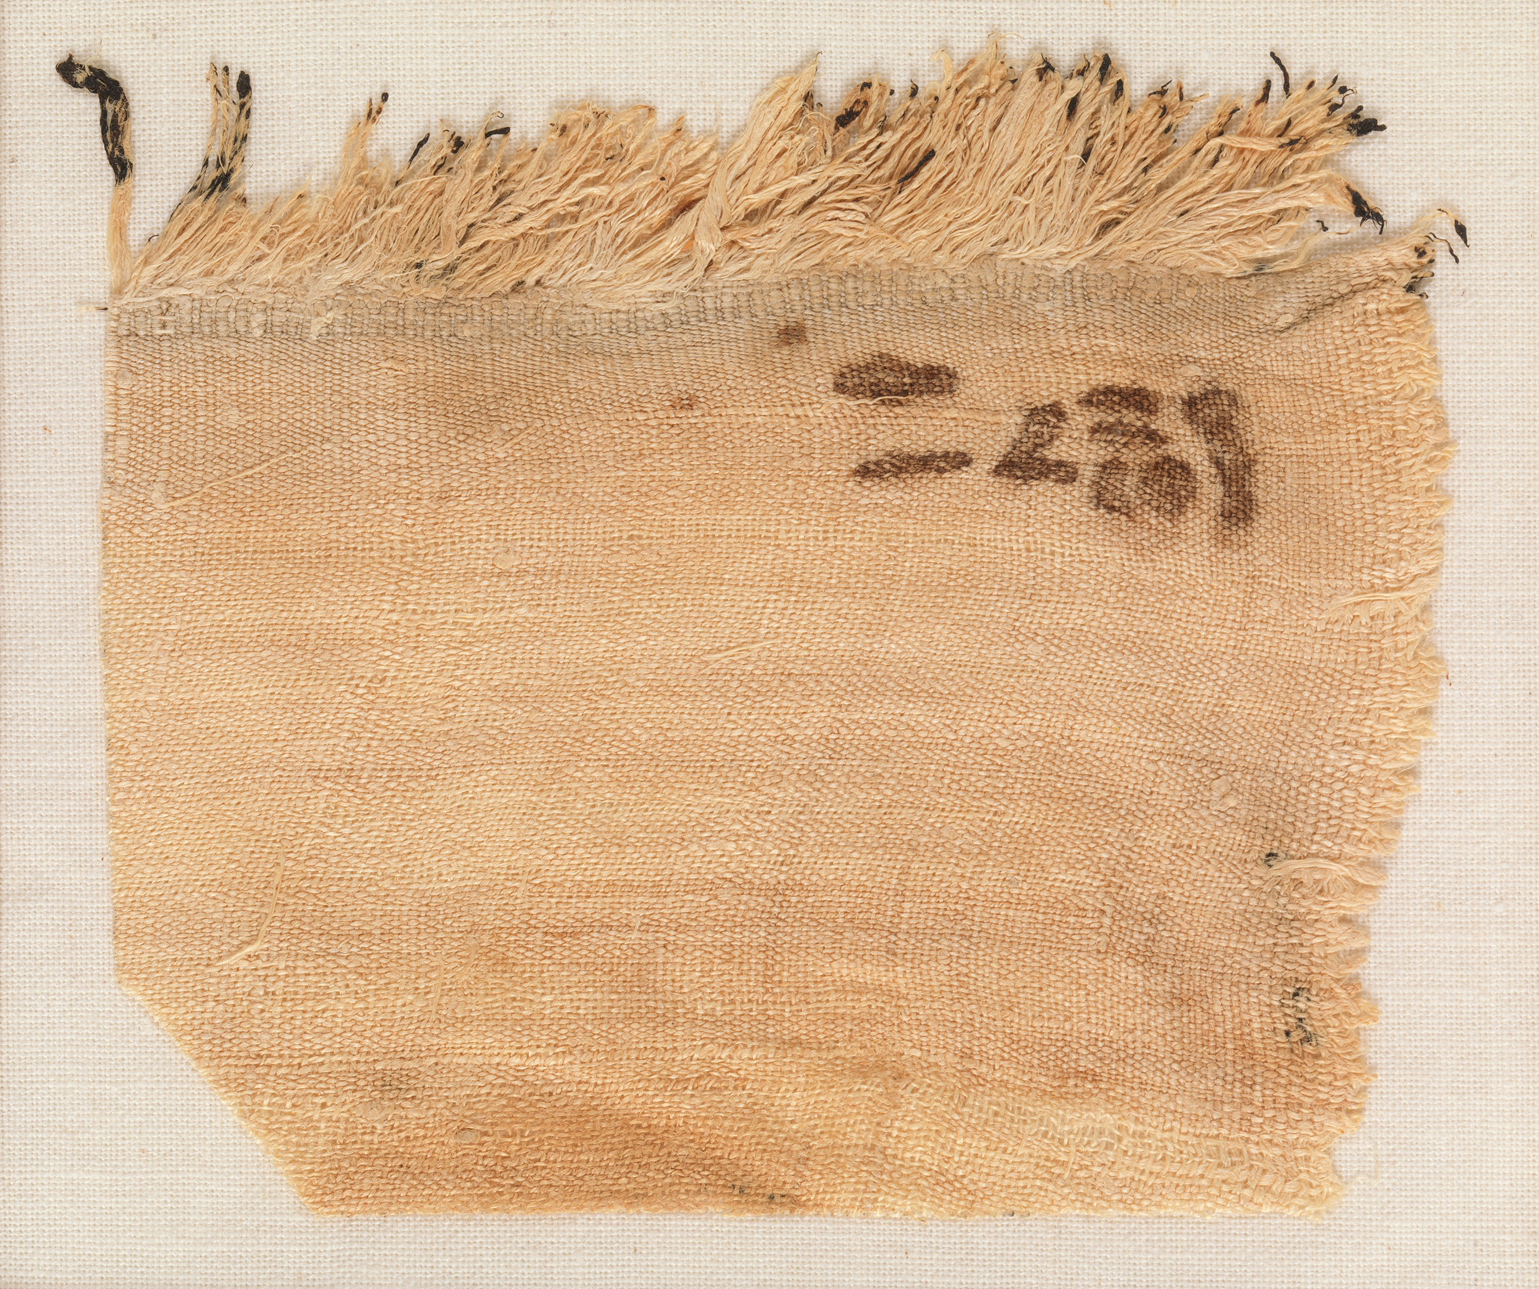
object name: linen mark, wah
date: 1981-1975 BCE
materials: linen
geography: egypt